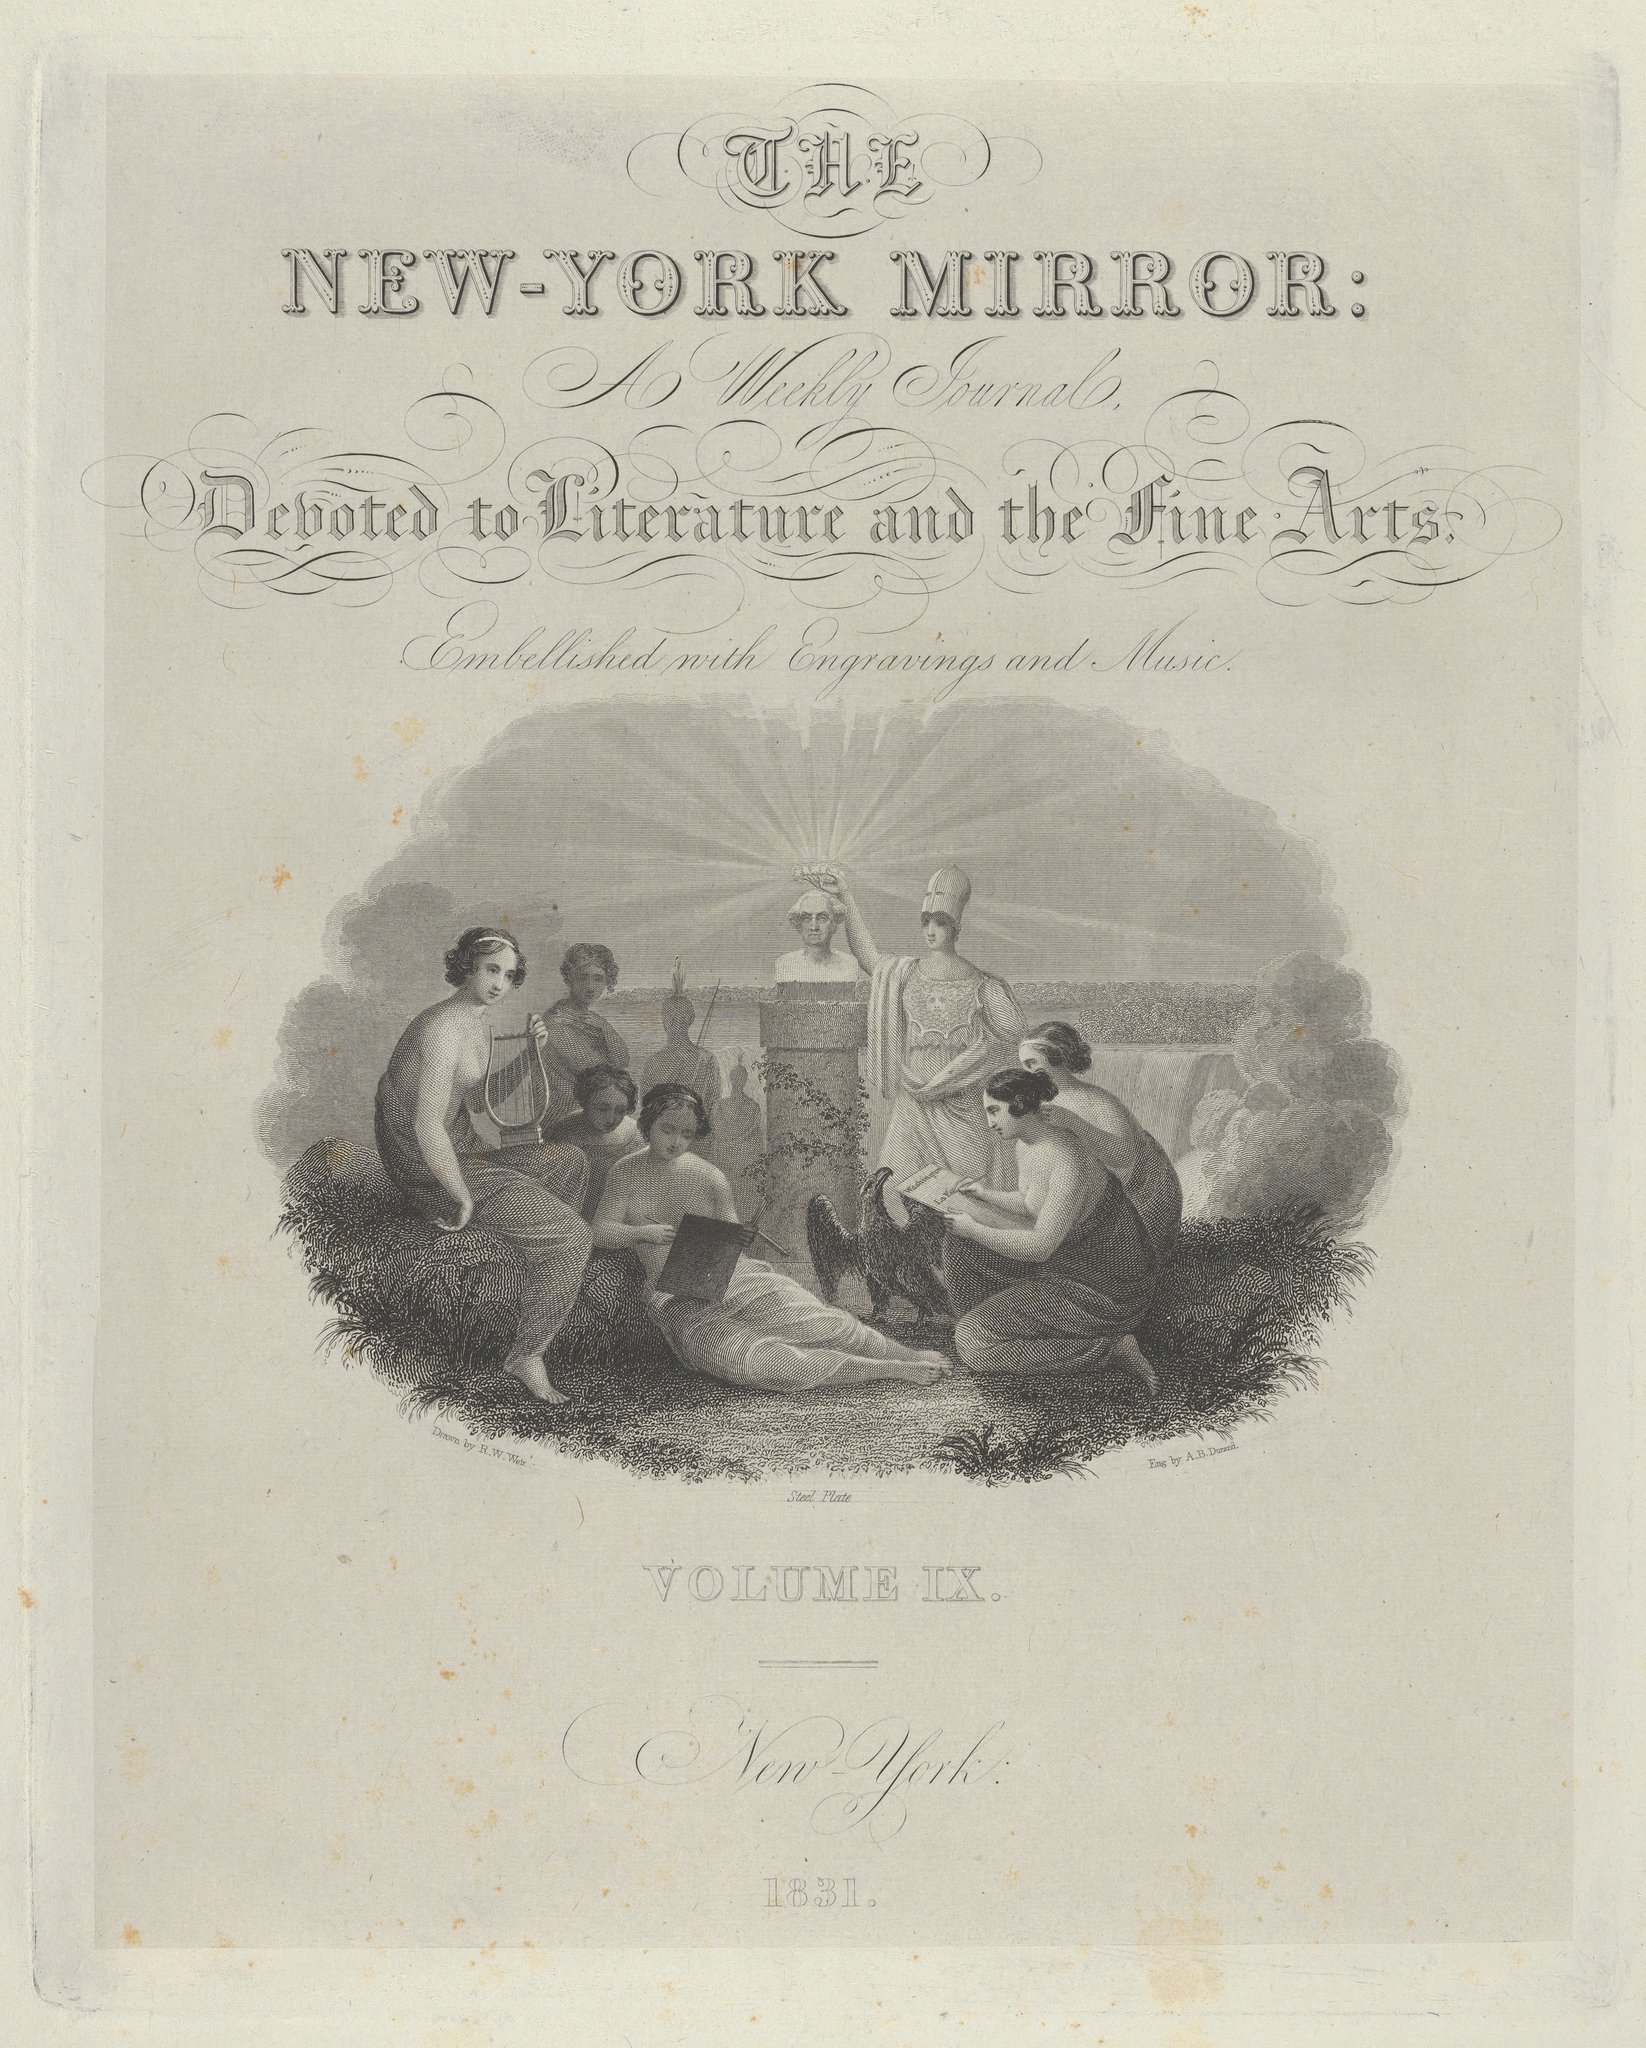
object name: print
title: Title Page: The New York Mirror, A Weekly Journal, Devoted to Literature and the Fine Arts. Embellished with Engravings and Music, Volume IX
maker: asher brown durand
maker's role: artist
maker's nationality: american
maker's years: 1796-1886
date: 1831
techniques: printmaking, engraving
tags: eagles,men,women,writing